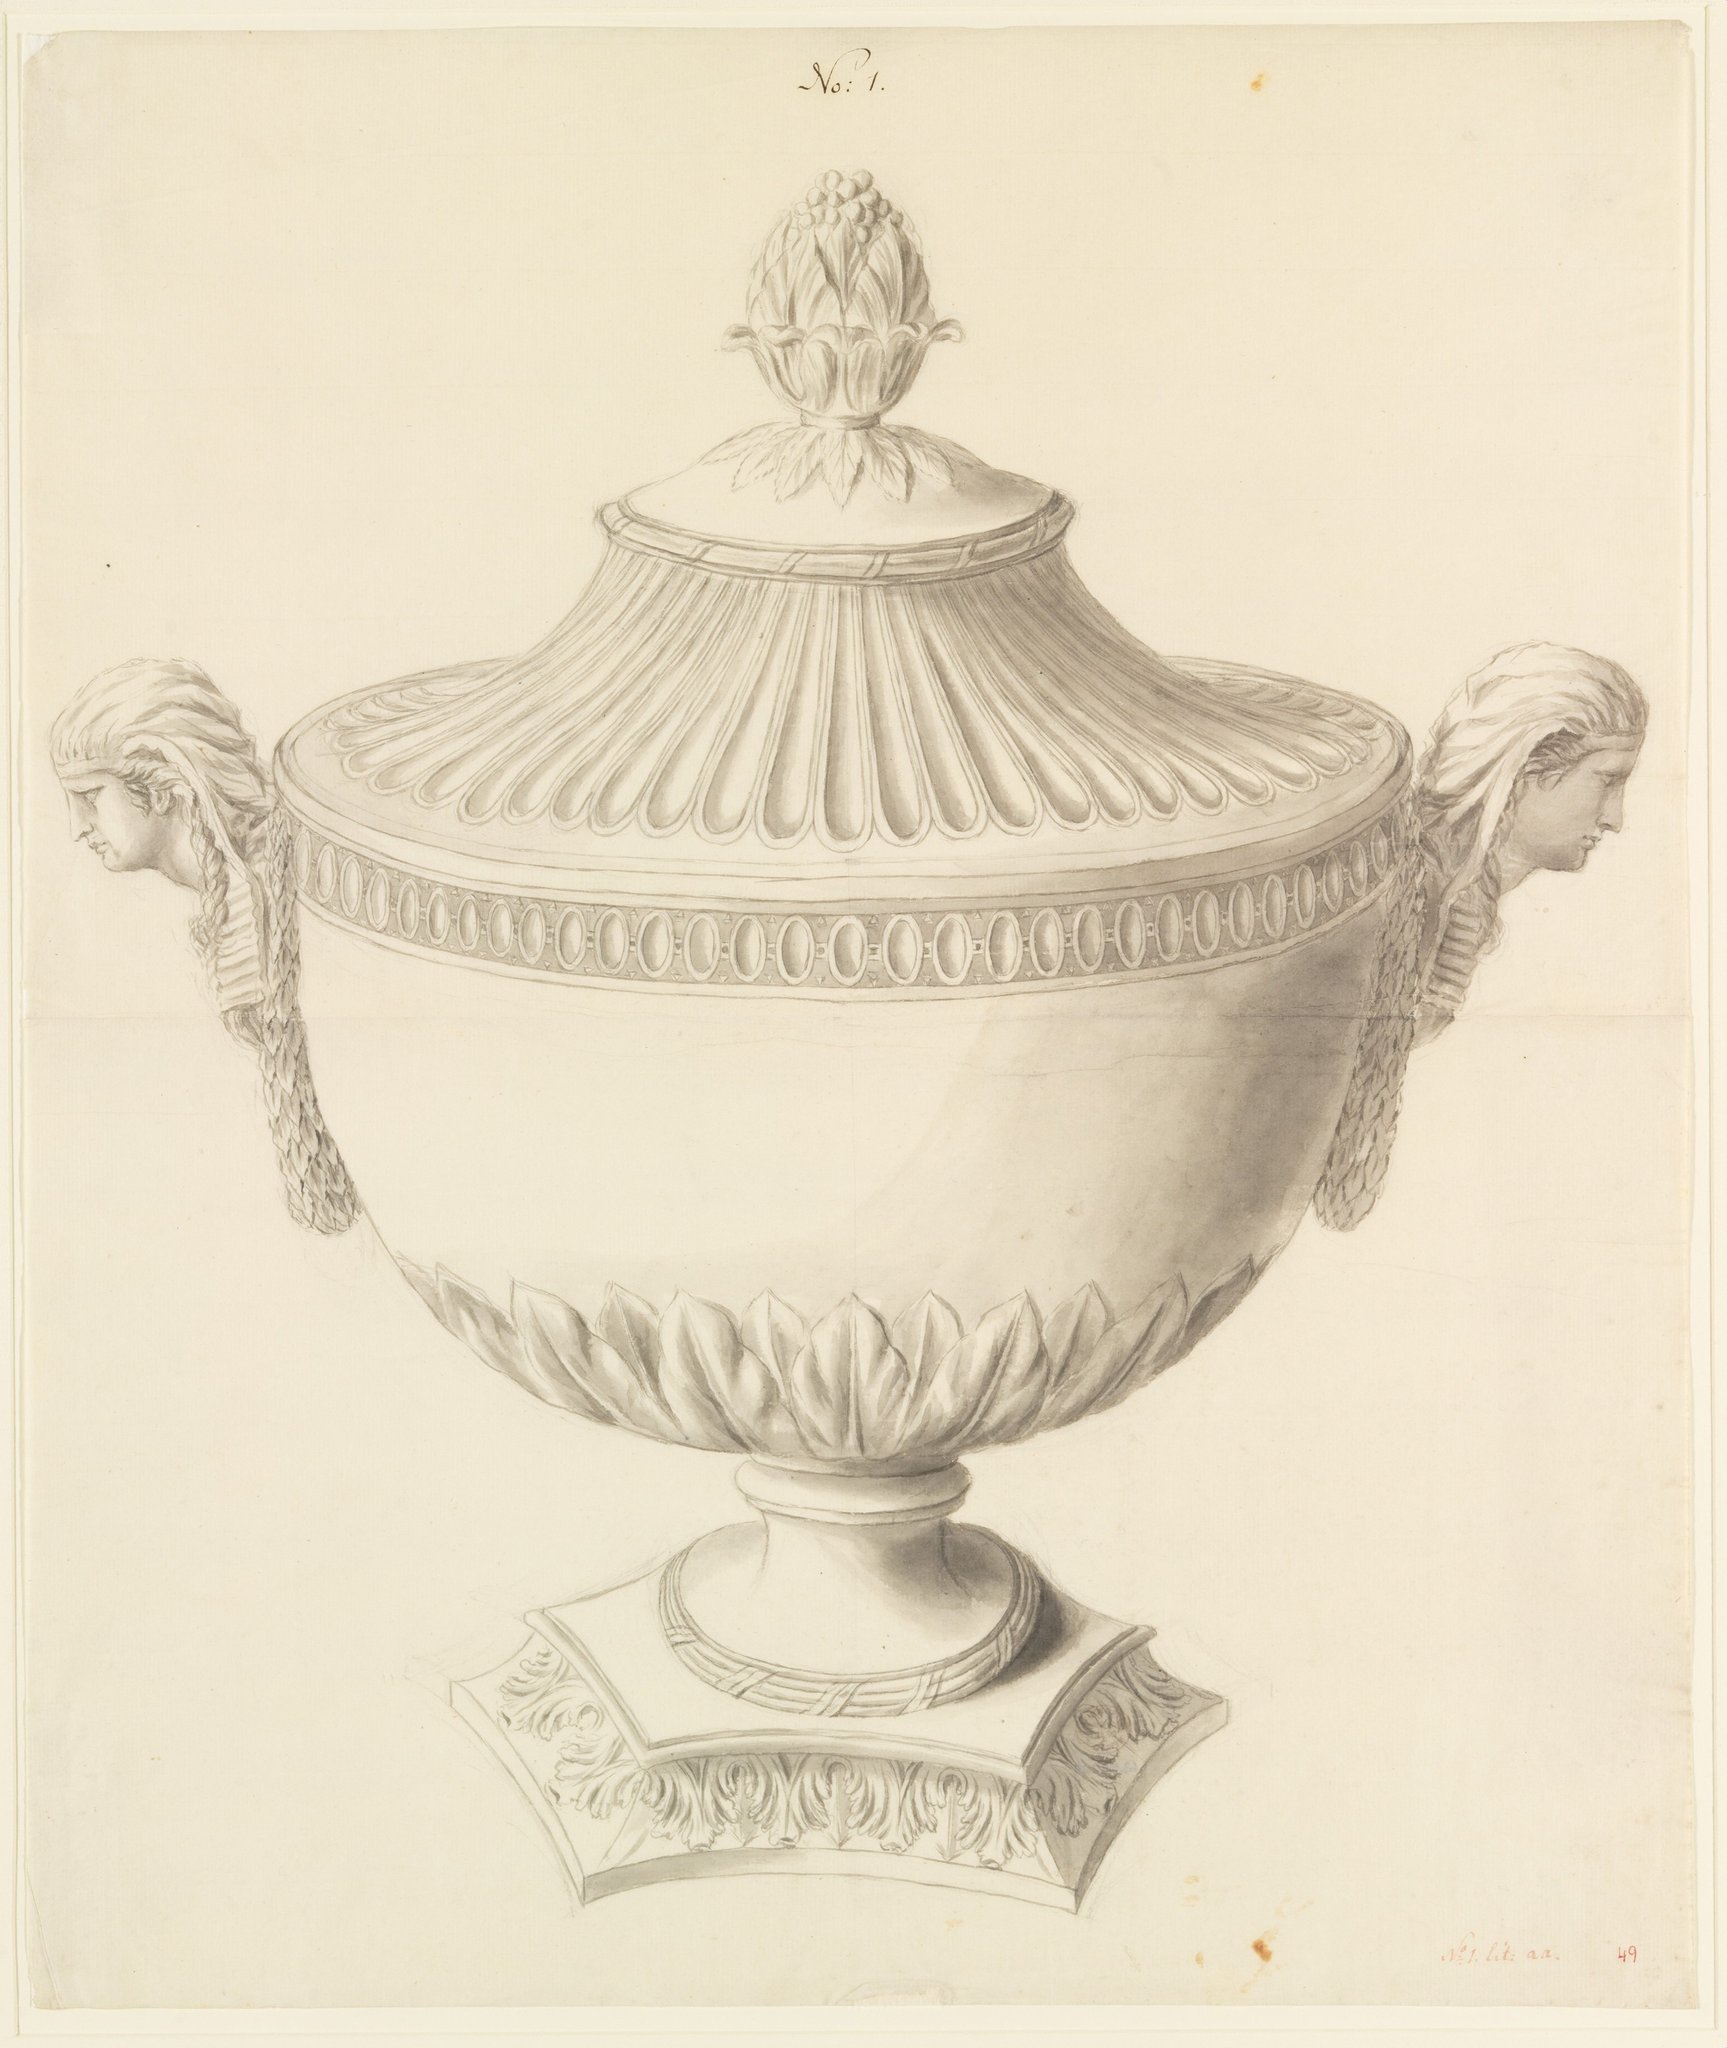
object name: drawing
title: Design for a Lidded Tureen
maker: anonymous, french, 18th century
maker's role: artist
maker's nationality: french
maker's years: 1700-1800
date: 1770-1790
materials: graphite, ink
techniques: brush, pen, drawing, wash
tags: tureens